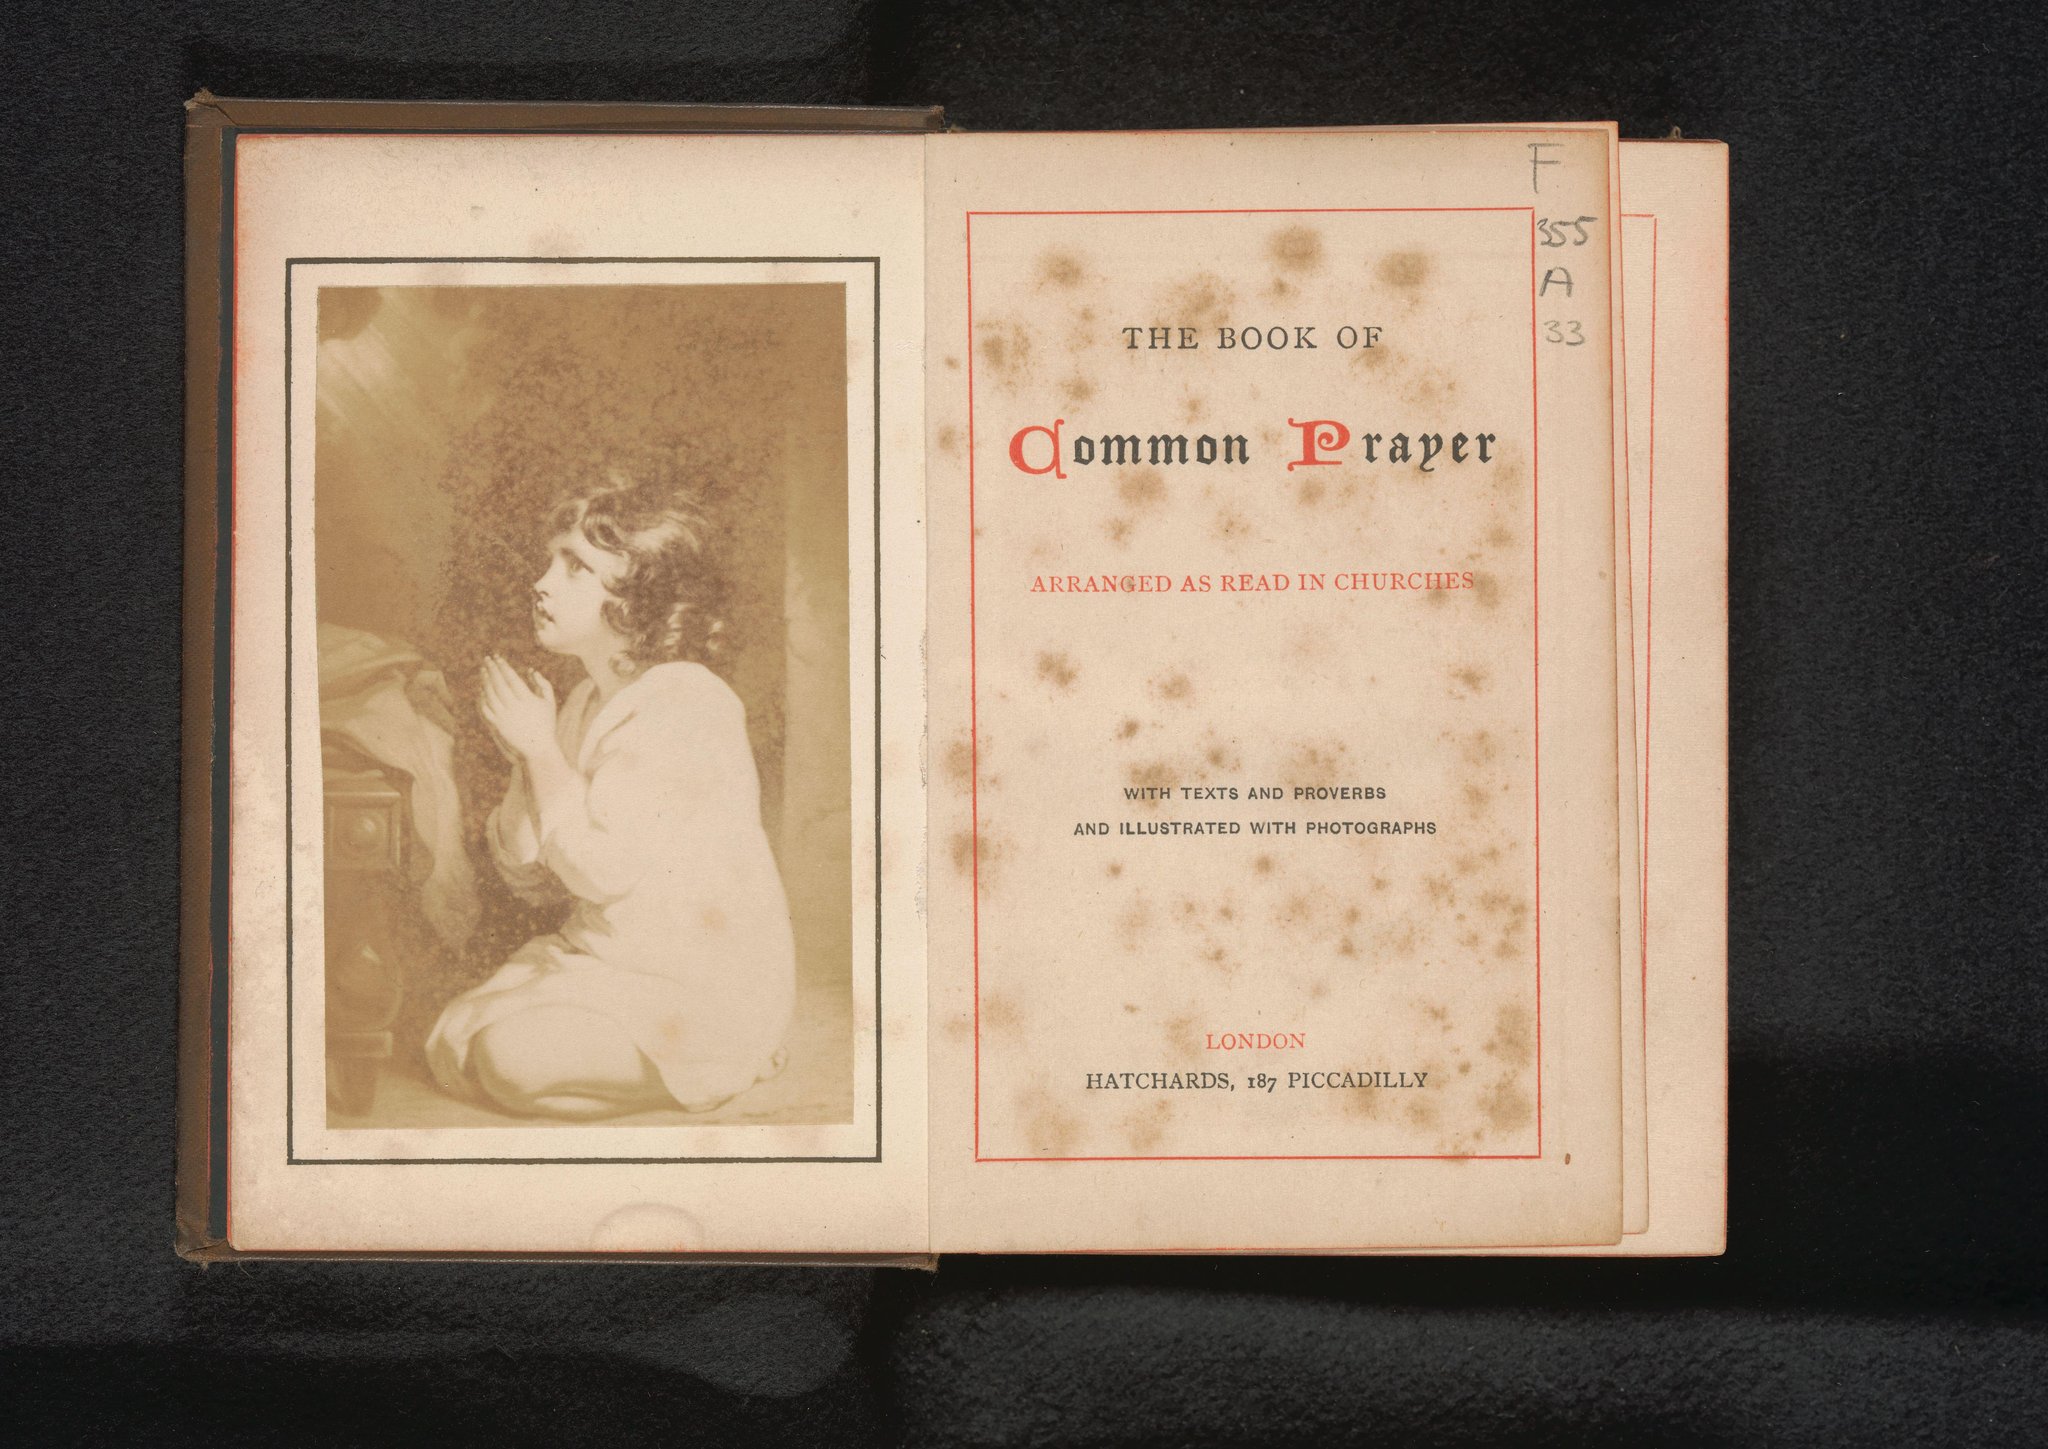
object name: book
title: The book of common prayer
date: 1880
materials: cardboard, linen, paper, photographic support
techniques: albumen print, printing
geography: london